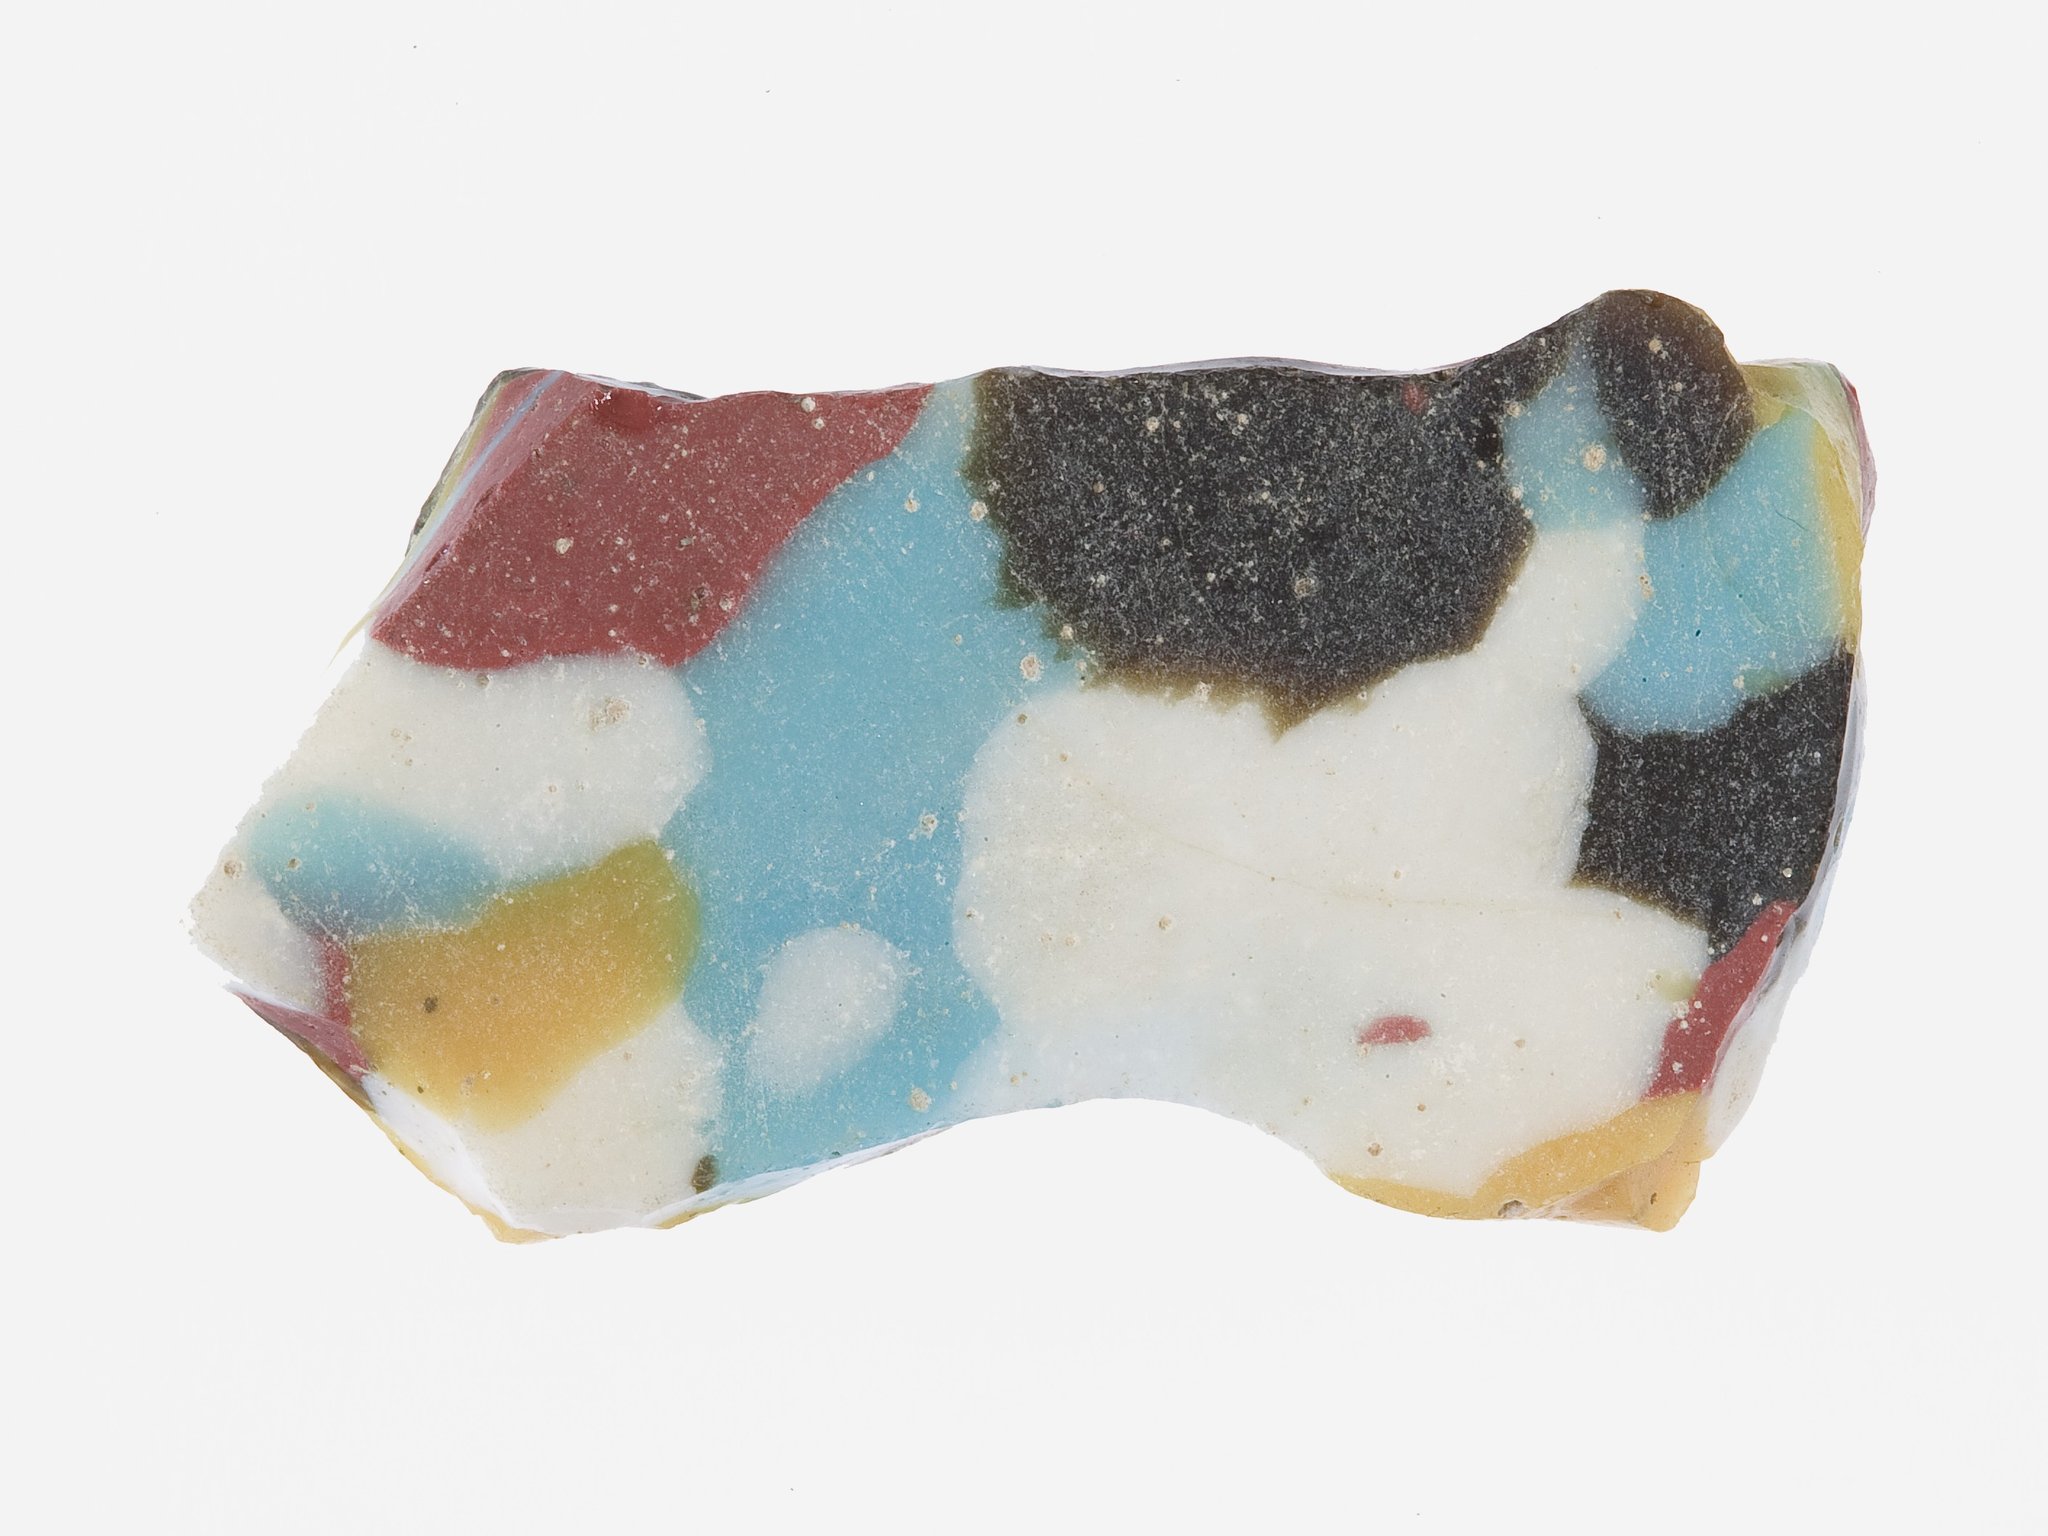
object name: vessel fragment, mosaic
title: Fragment of a Dish of Polychrome Mosaic Glass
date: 1390-1352 BCE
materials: glass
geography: egypt